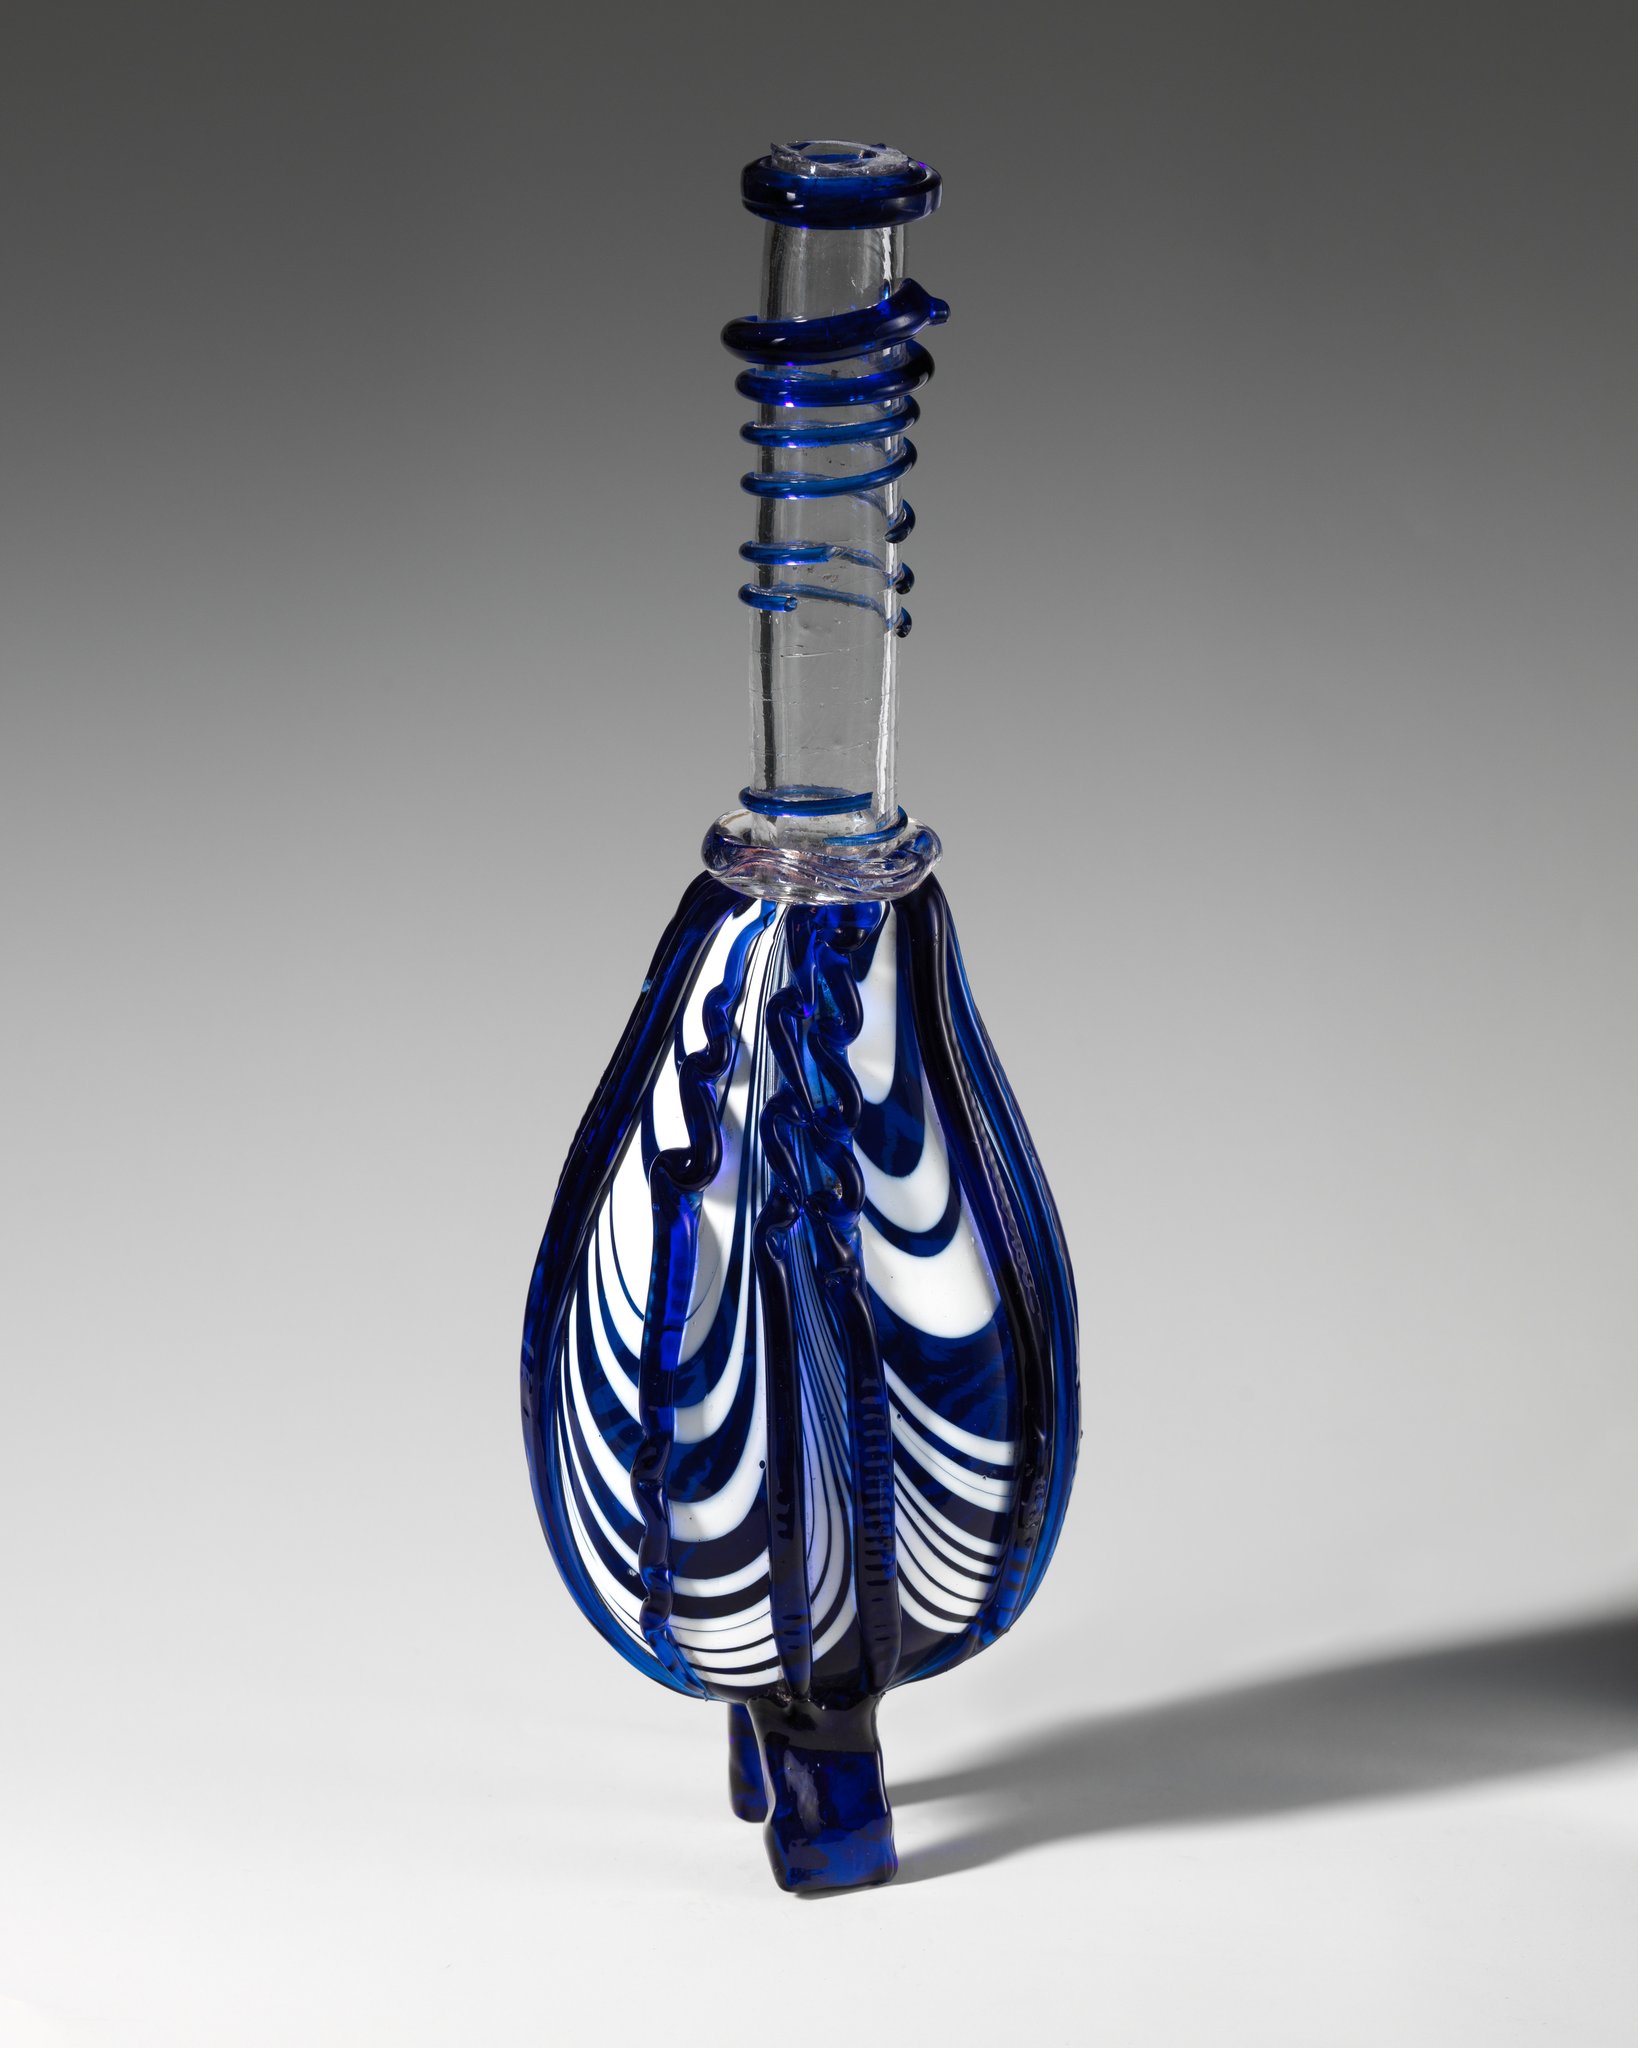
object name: bellow model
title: Bellows model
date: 1767-1833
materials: glass